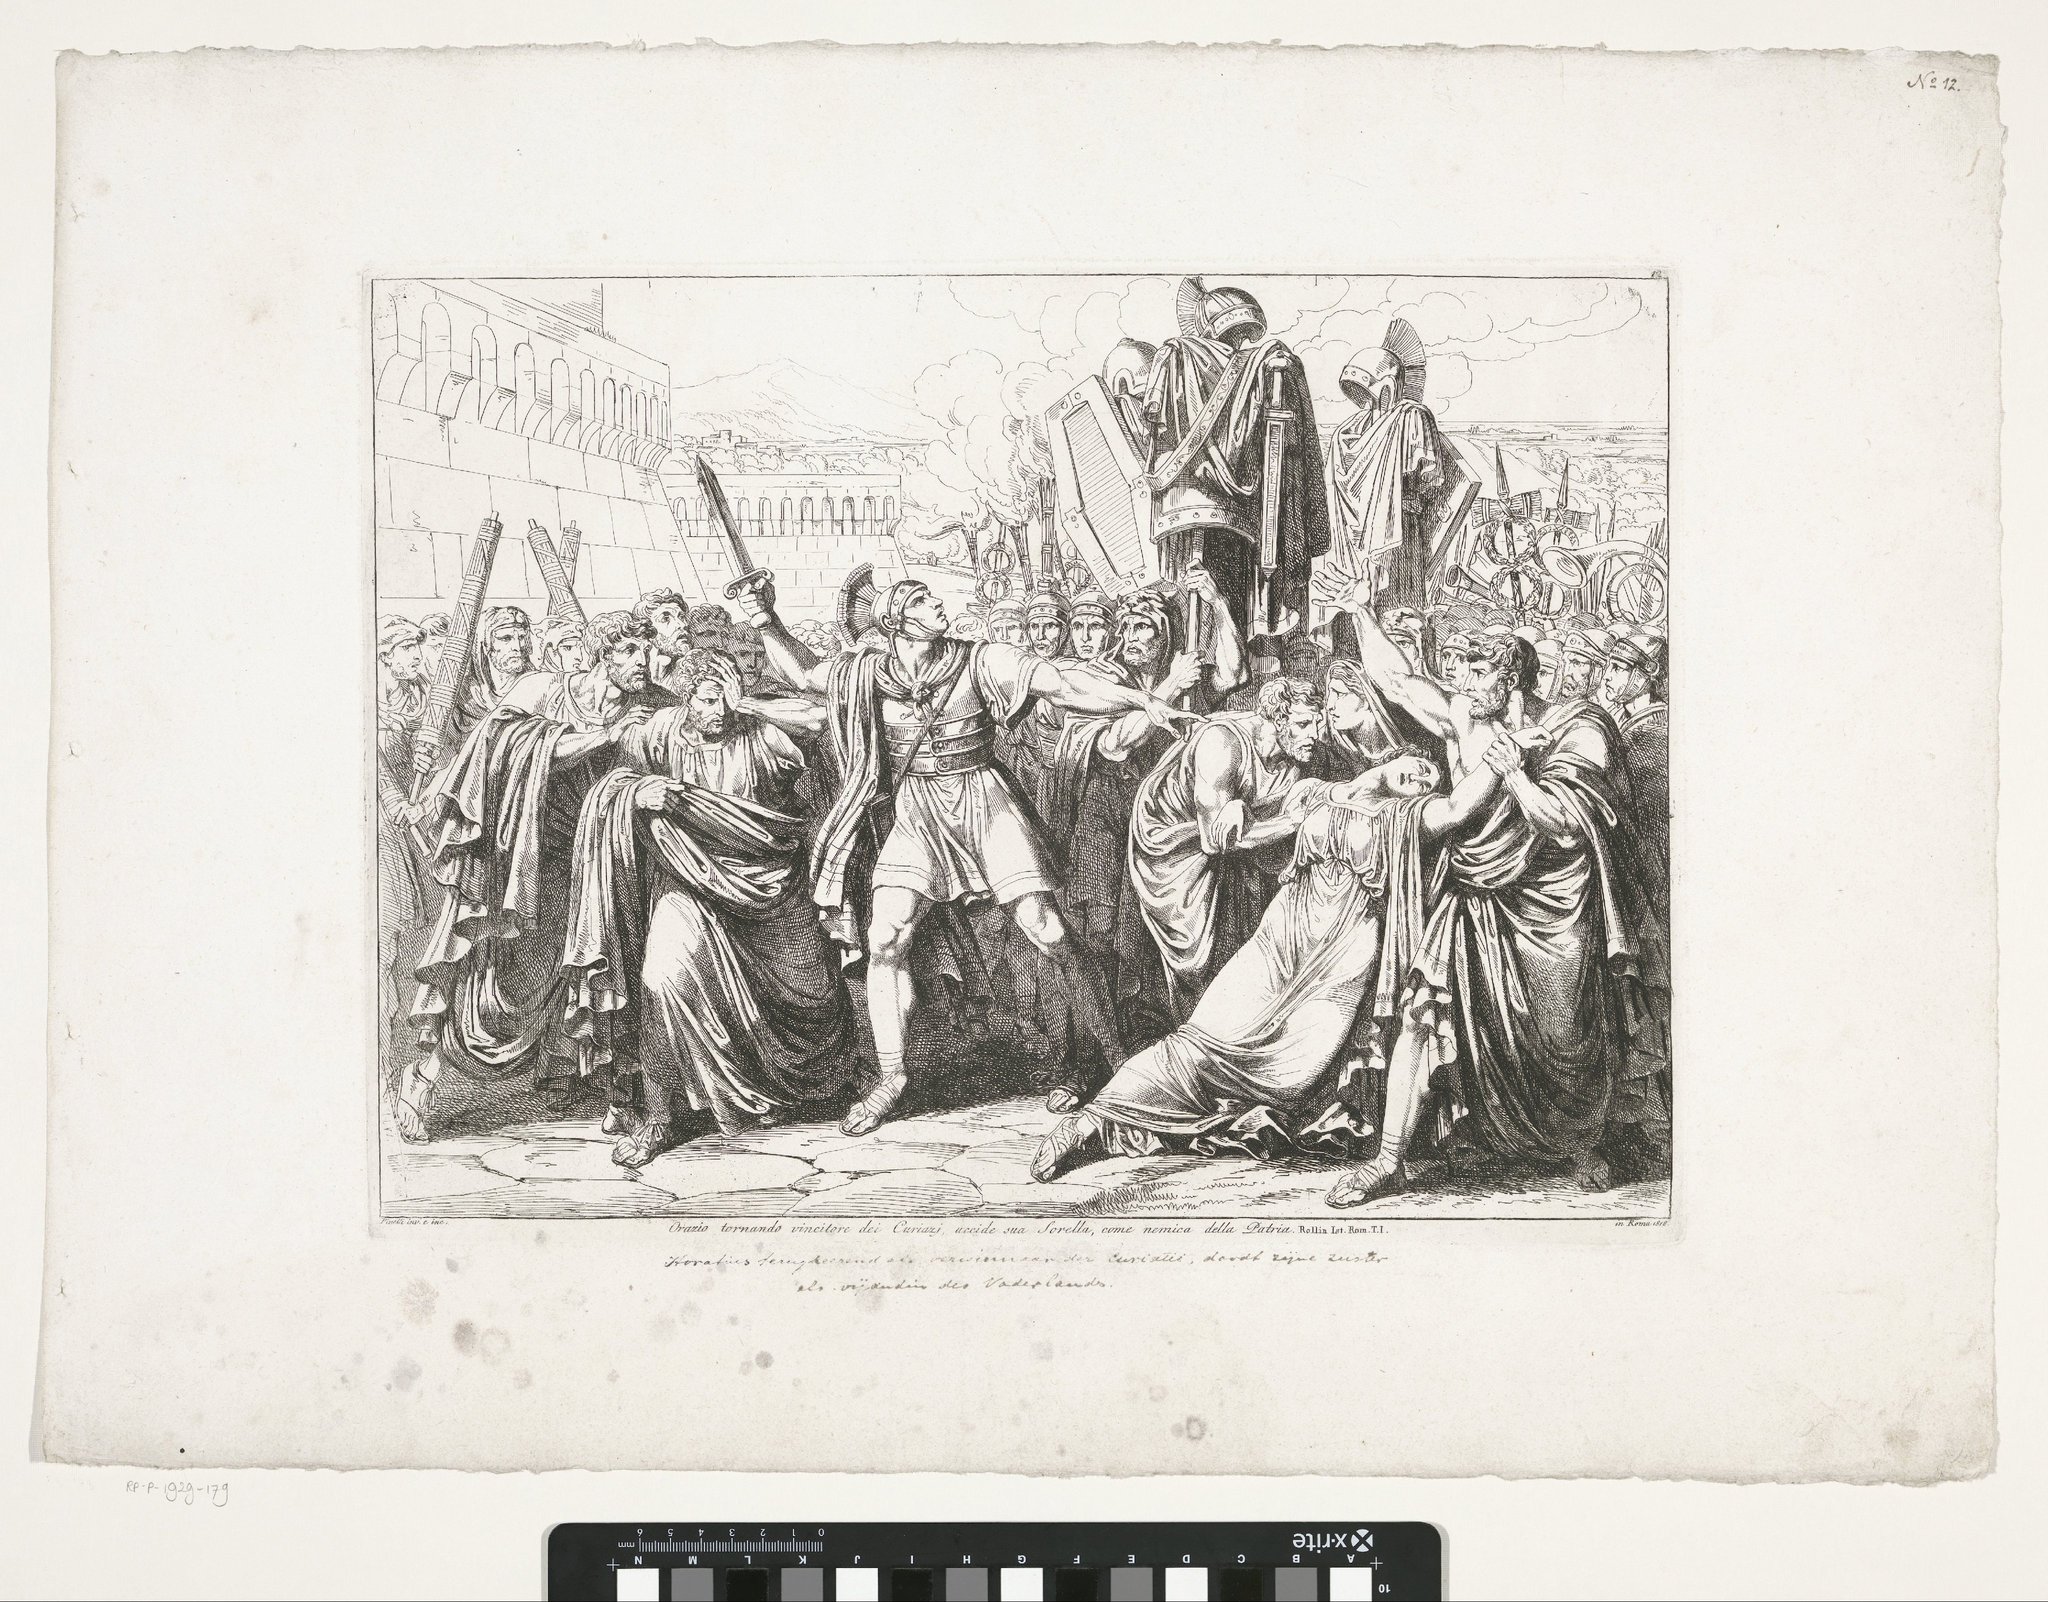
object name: print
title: Publius Horatius vermoordt zijn zus Camilla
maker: bartolomeo pinelli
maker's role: draughtsman, print maker, sculptor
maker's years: 1781-1835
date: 1818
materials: paper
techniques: etching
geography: rome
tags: horatius slays his sister for rebuking him about the death of one of the curiatii, with whom she was betrothed, rome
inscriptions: inscription: ‘Horatius terugkeerend als overwinnaar der Curuatii, doodt zijne zuster / als vijandin des vaderlands.’, collector's mark: Lugt 2228, number: ‘No 12.’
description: Publius Horatius vermoordt zijn zus Camilla bij terugkomst in Rome, na het doden van de Curatii. Een menigte mannen kijkt toe.